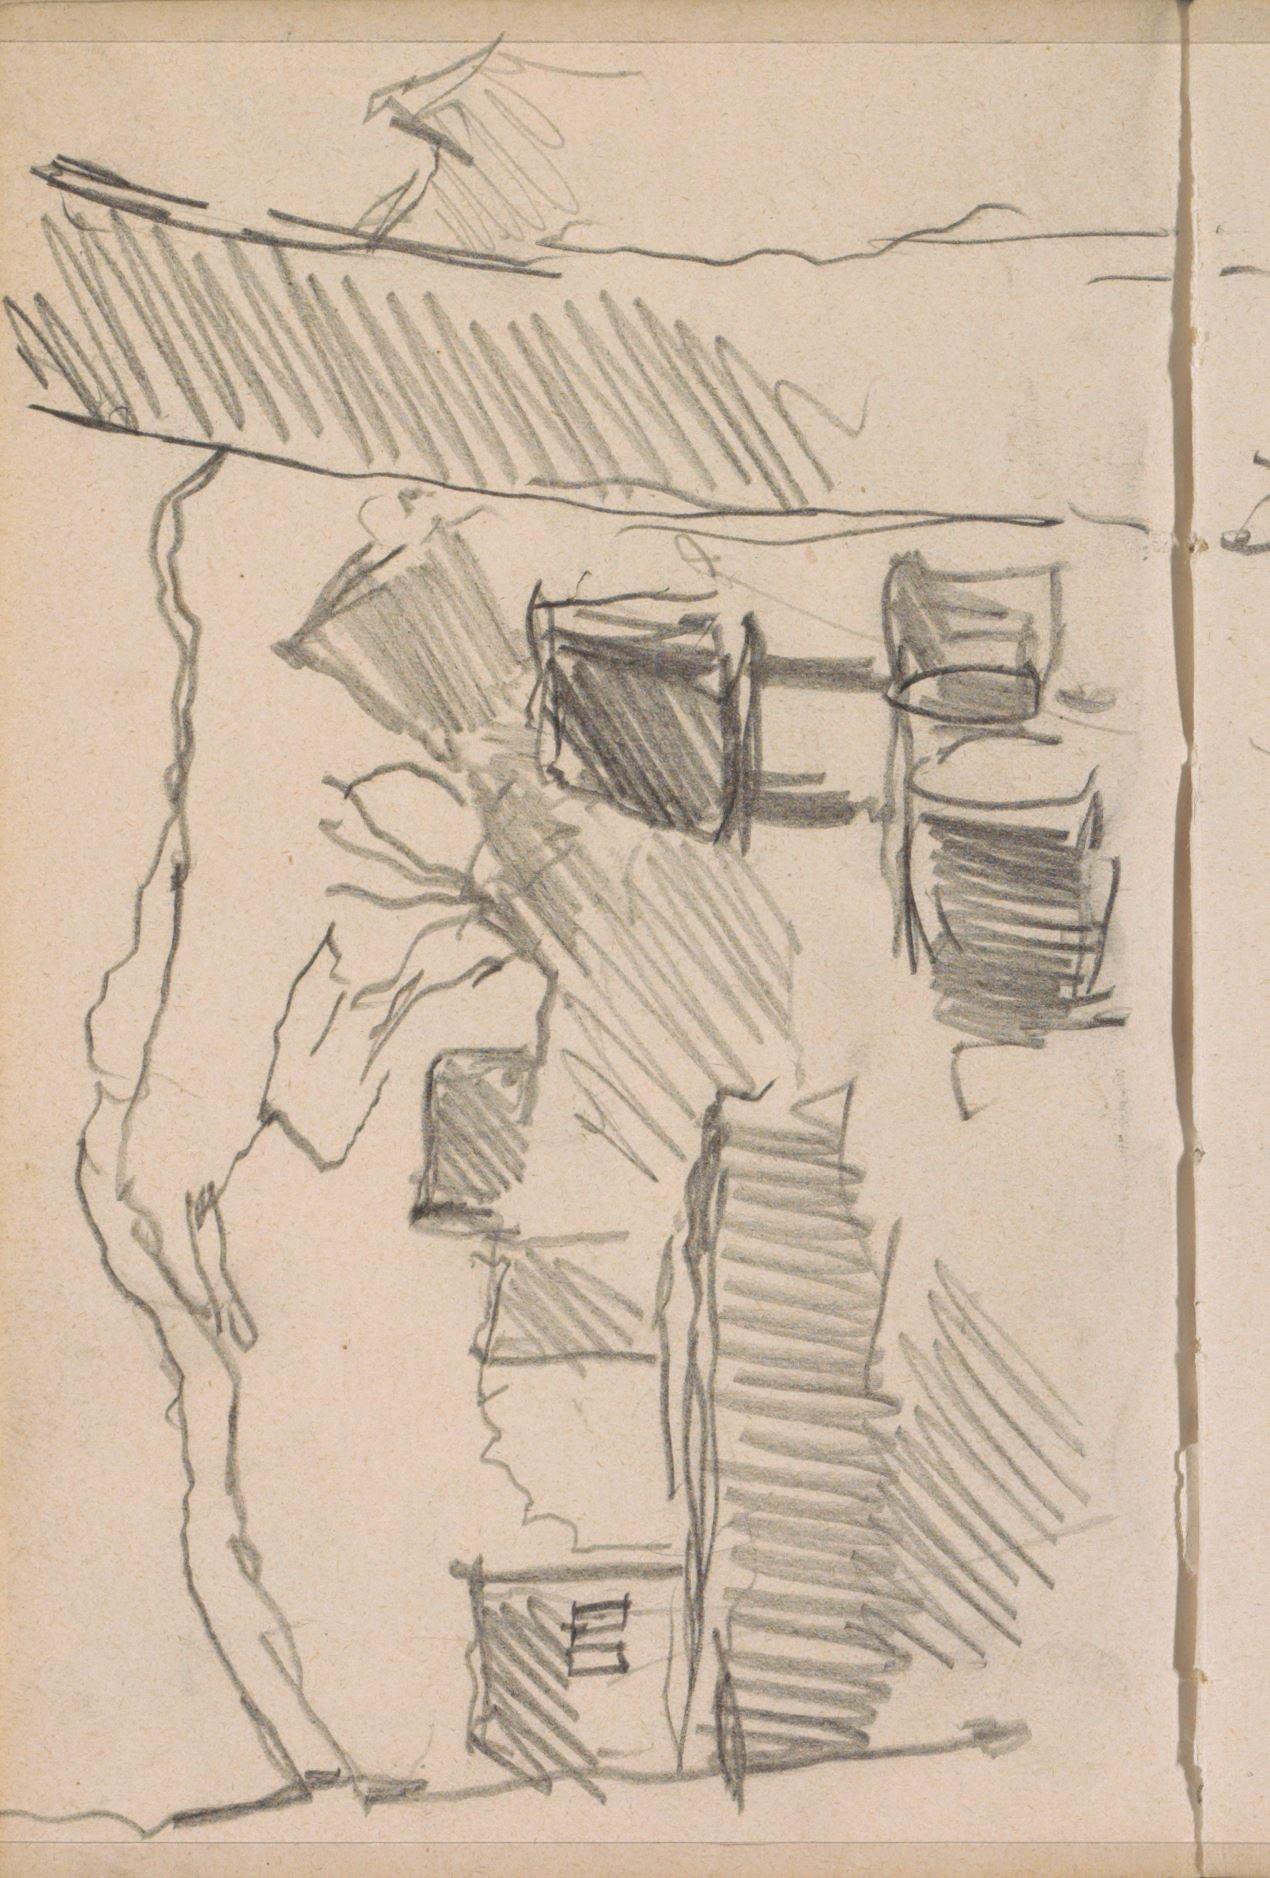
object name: sketchbook leaf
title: Gezicht op de Nieuwe Teertuinen te Amsterdam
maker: george hendrik breitner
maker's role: draughtsman, painter, print maker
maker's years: 1857-1923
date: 1912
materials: paper, pencil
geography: amsterdam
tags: tools, aids, implements ~ crafts and industries, canals, waters (in city), civic architecture; edifices; dwellings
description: Vooraan de kraan van de teerkokerij. Pagina 15 uit een schetsboek met 16 bladen.